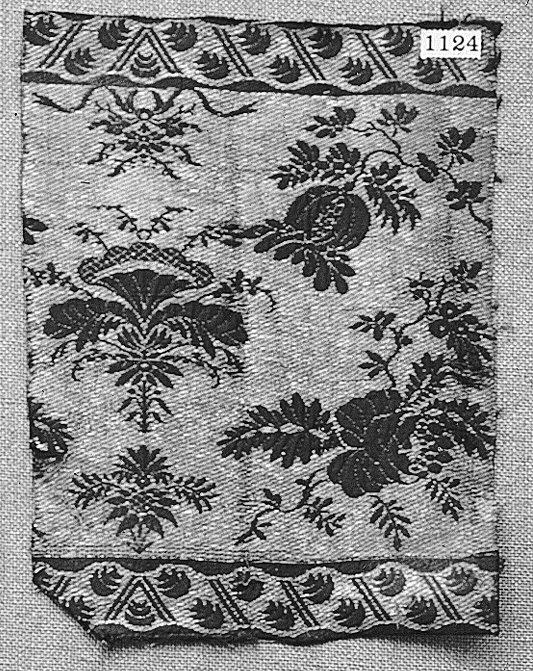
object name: ribbon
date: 1830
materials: metal thread